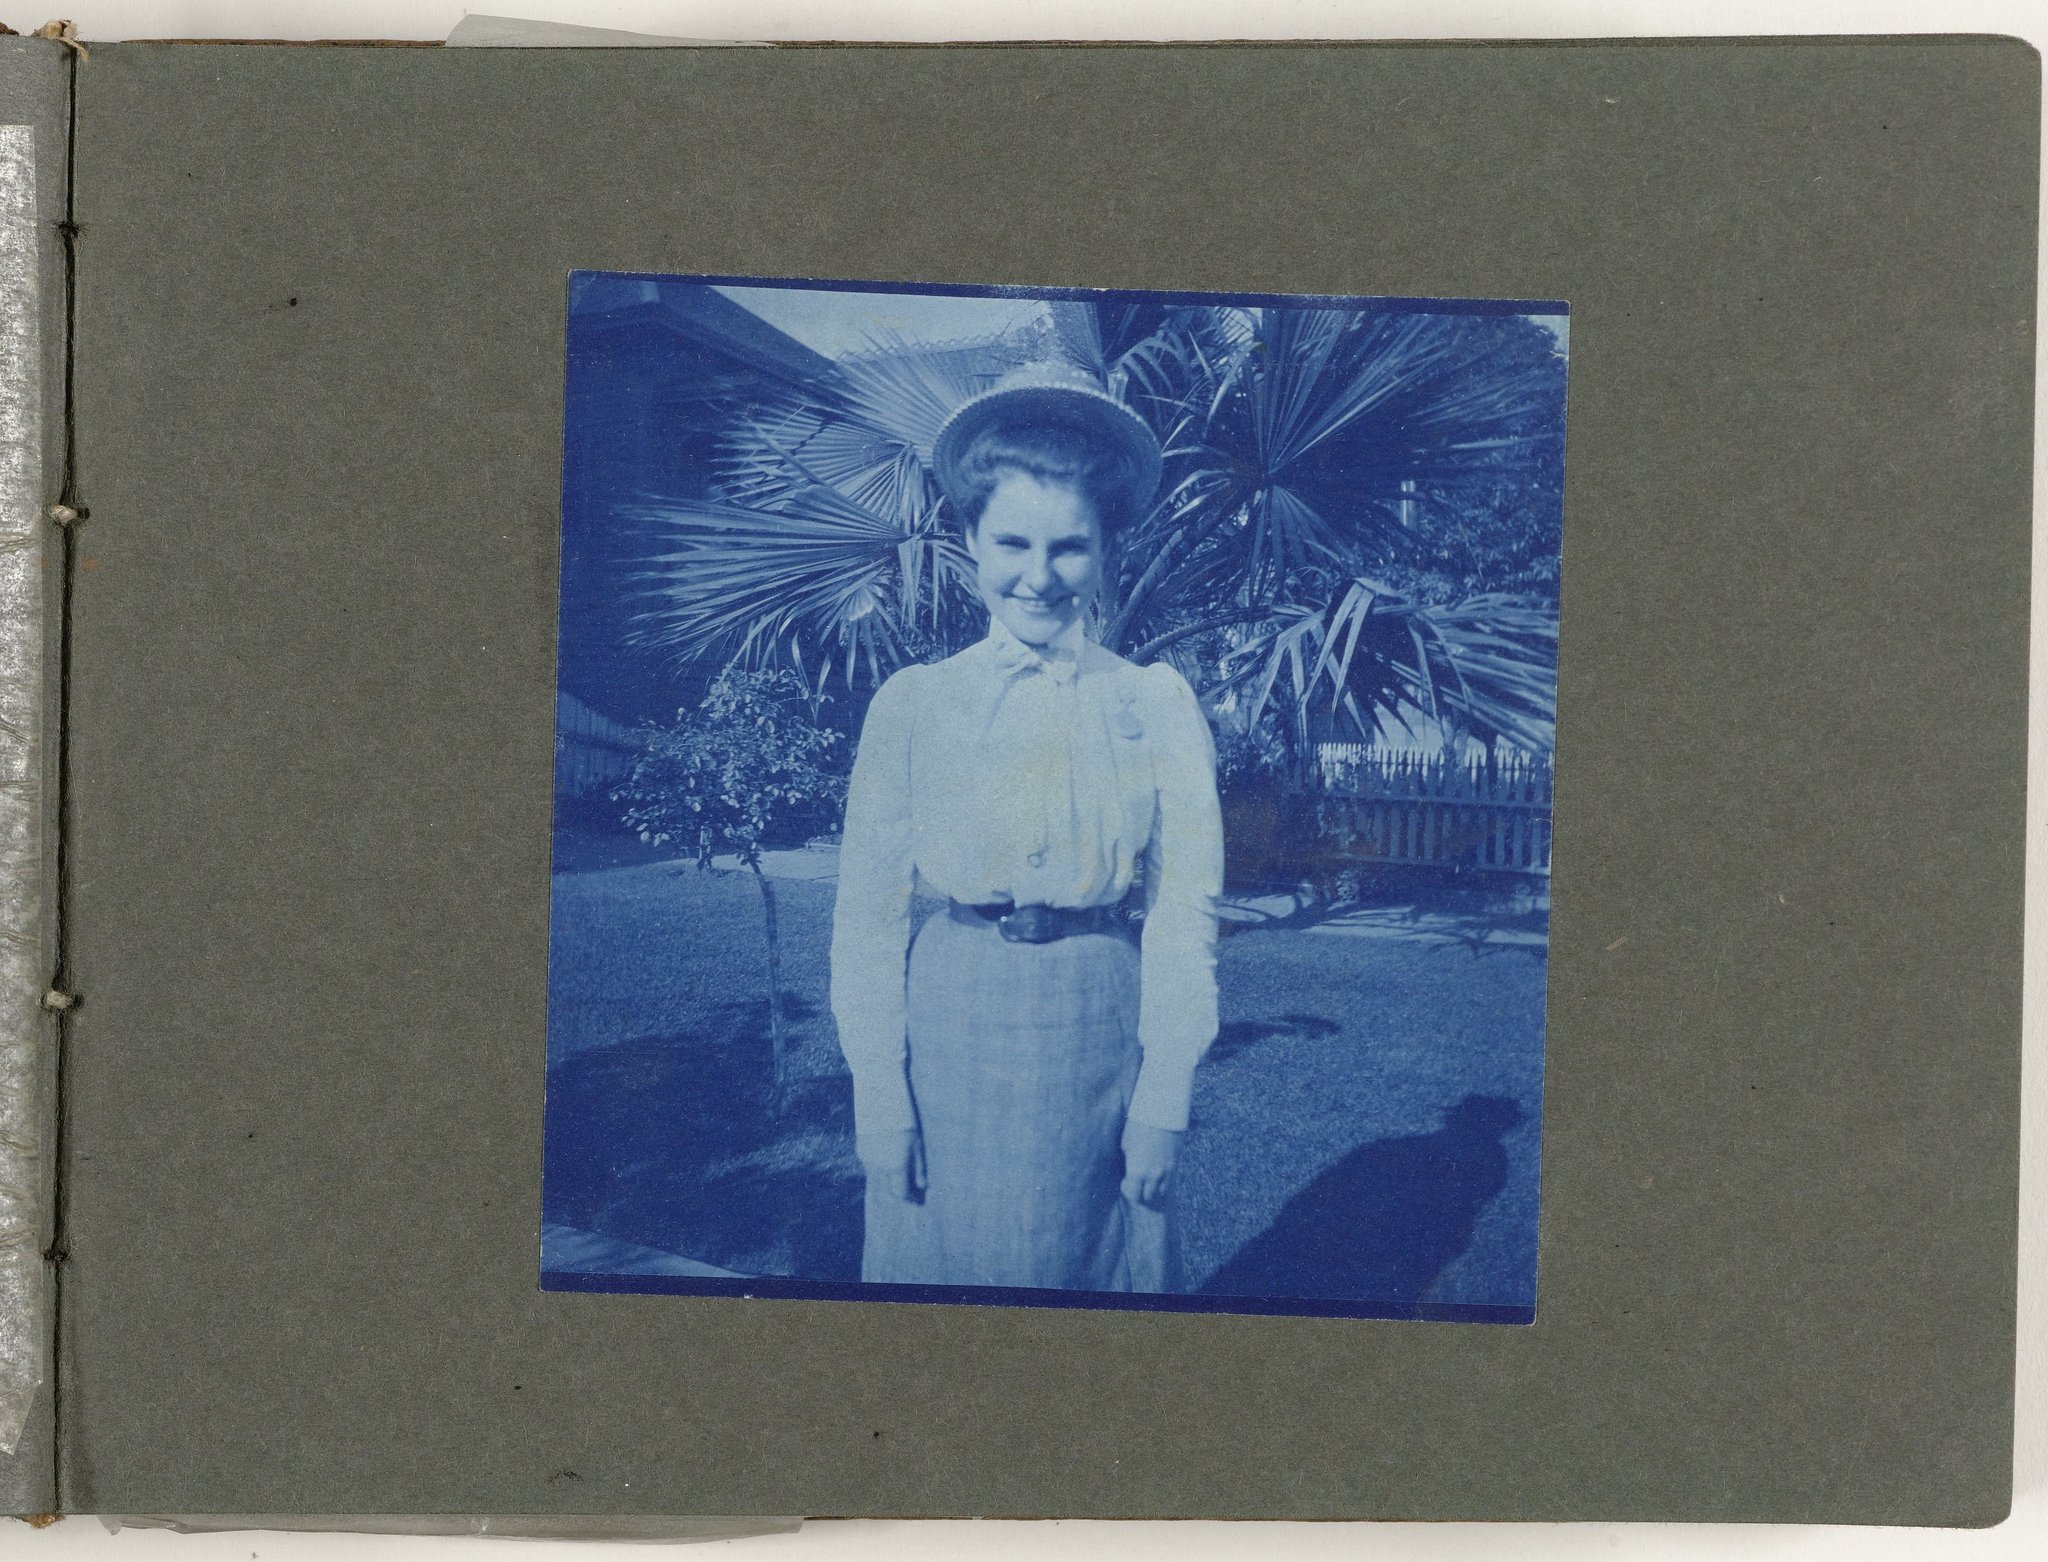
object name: photograph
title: Portret van een vrouw bij palmbomen, Verenigde Staten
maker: Anonymous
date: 1900-1920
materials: paper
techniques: cyanotype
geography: united states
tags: historical persons not known by name - bb - woman, trees: palm-tree, united states of america